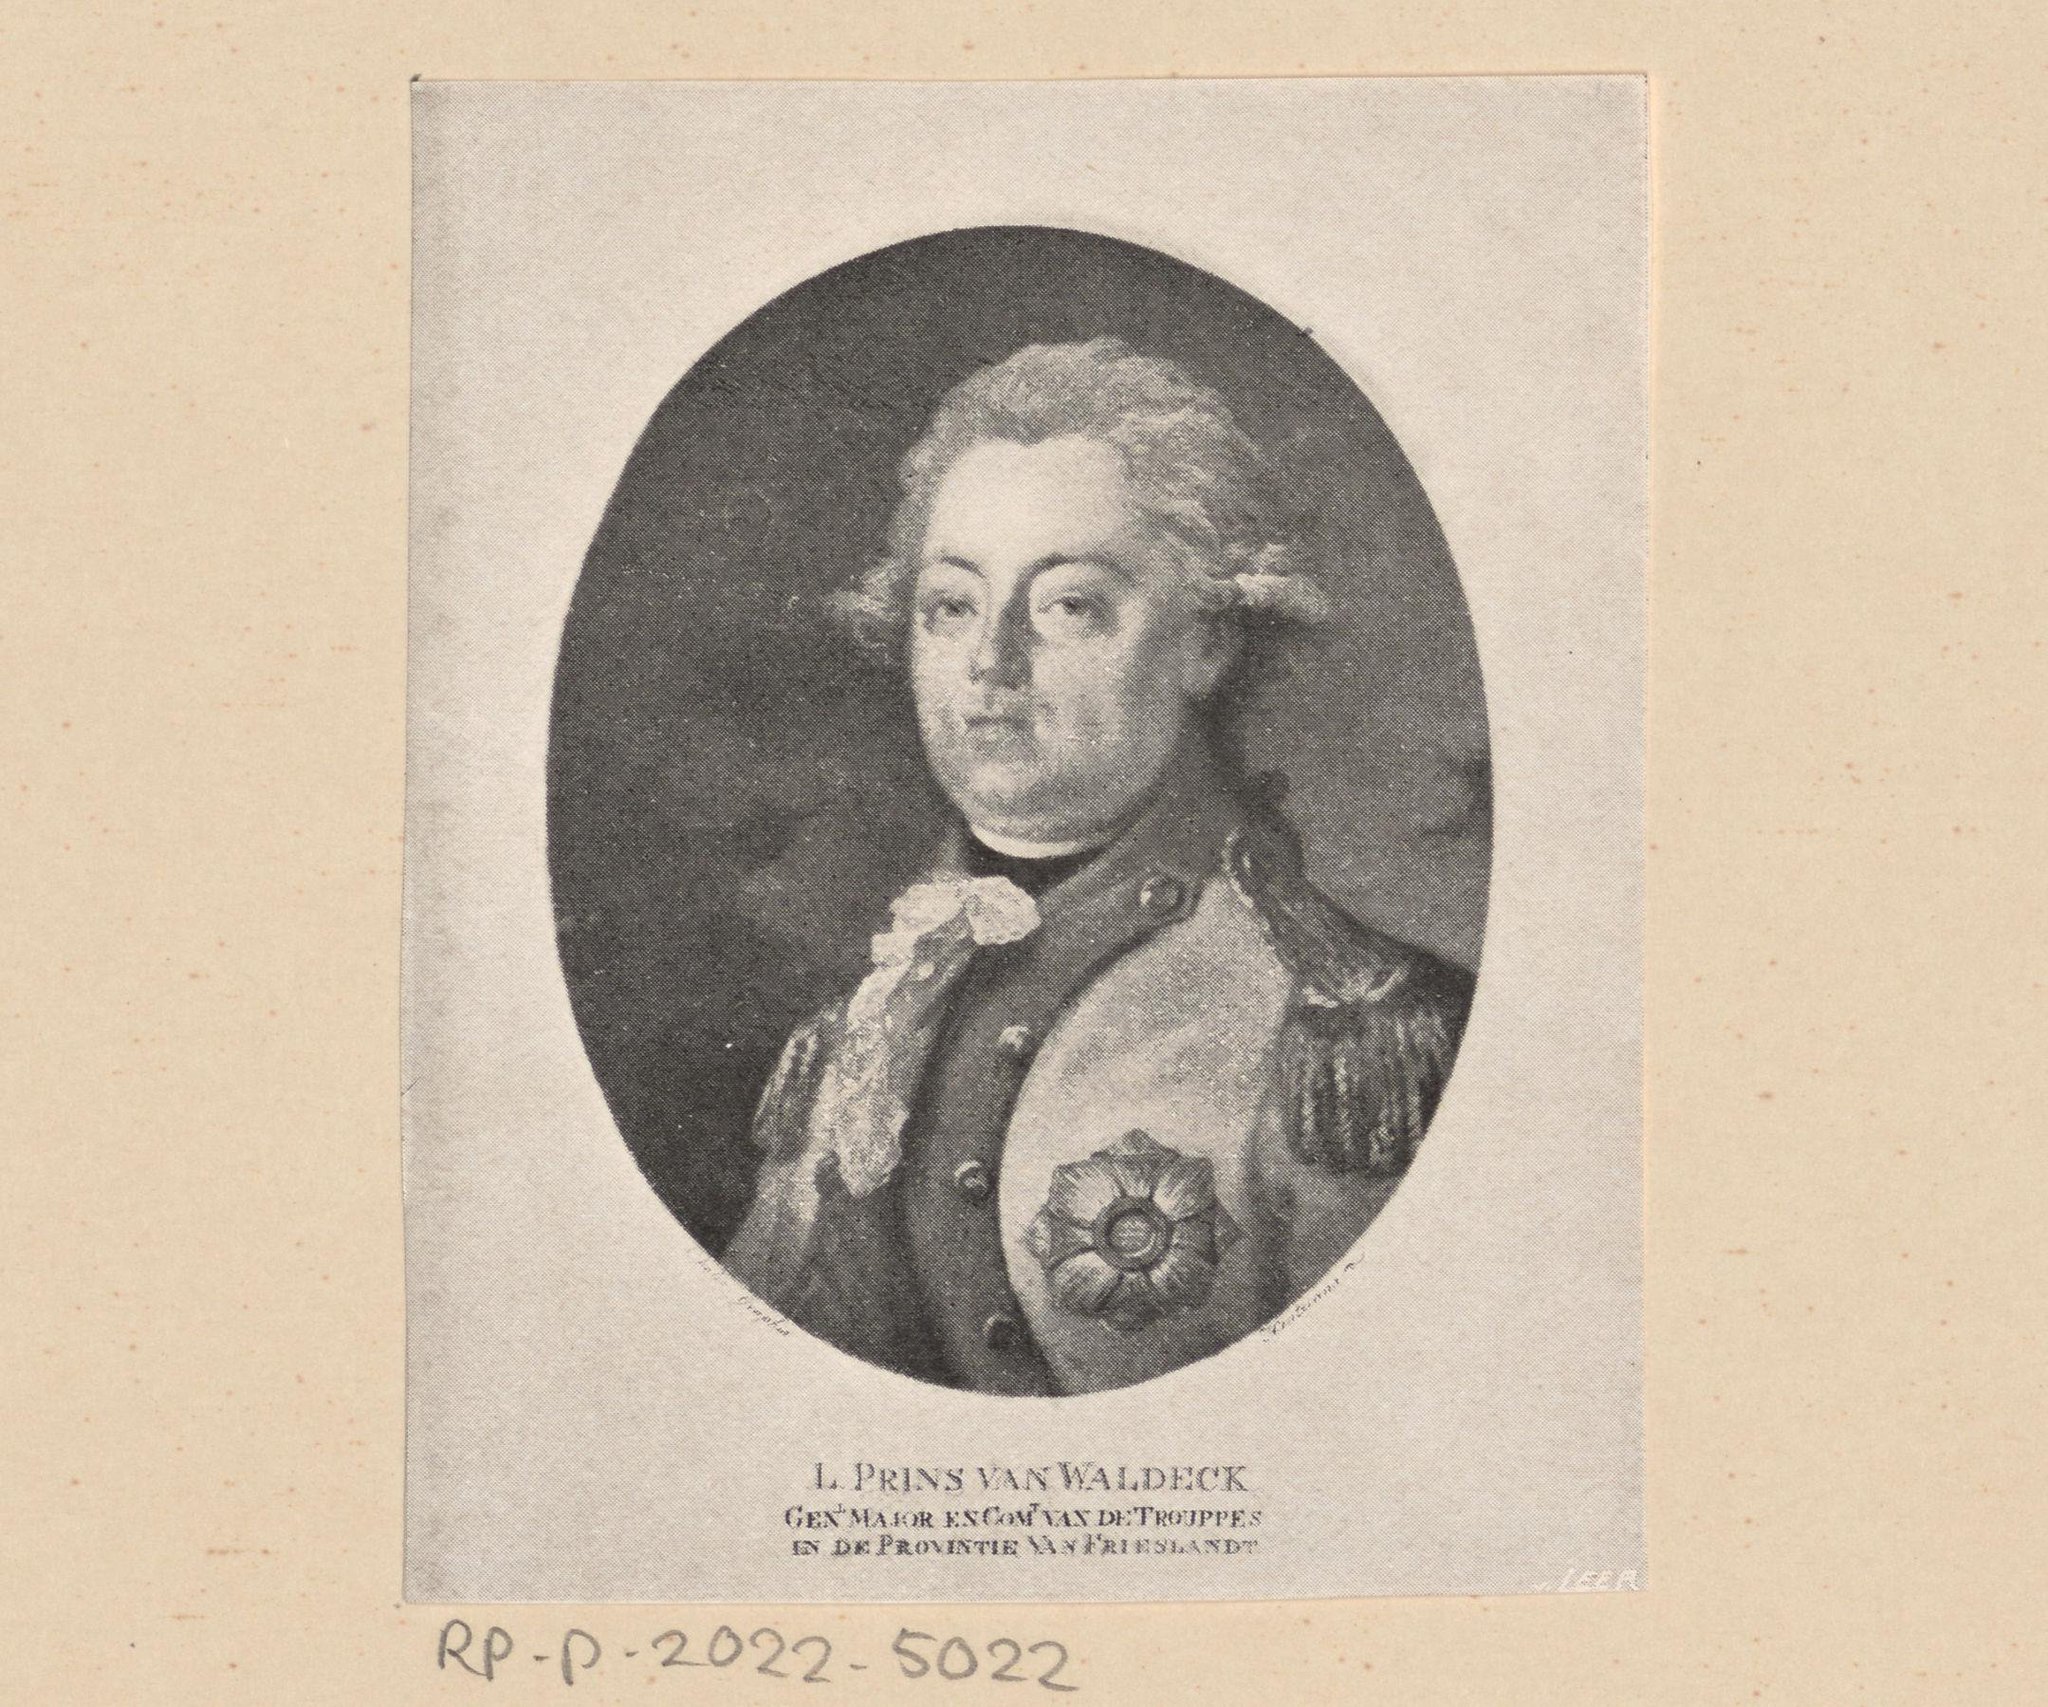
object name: photomechanical print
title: Portret van Lodewijk prins van Waldeck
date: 1882-1913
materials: paper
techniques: autotype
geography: netherlands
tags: commander-in-chief, general, marshal, prince, historical persons